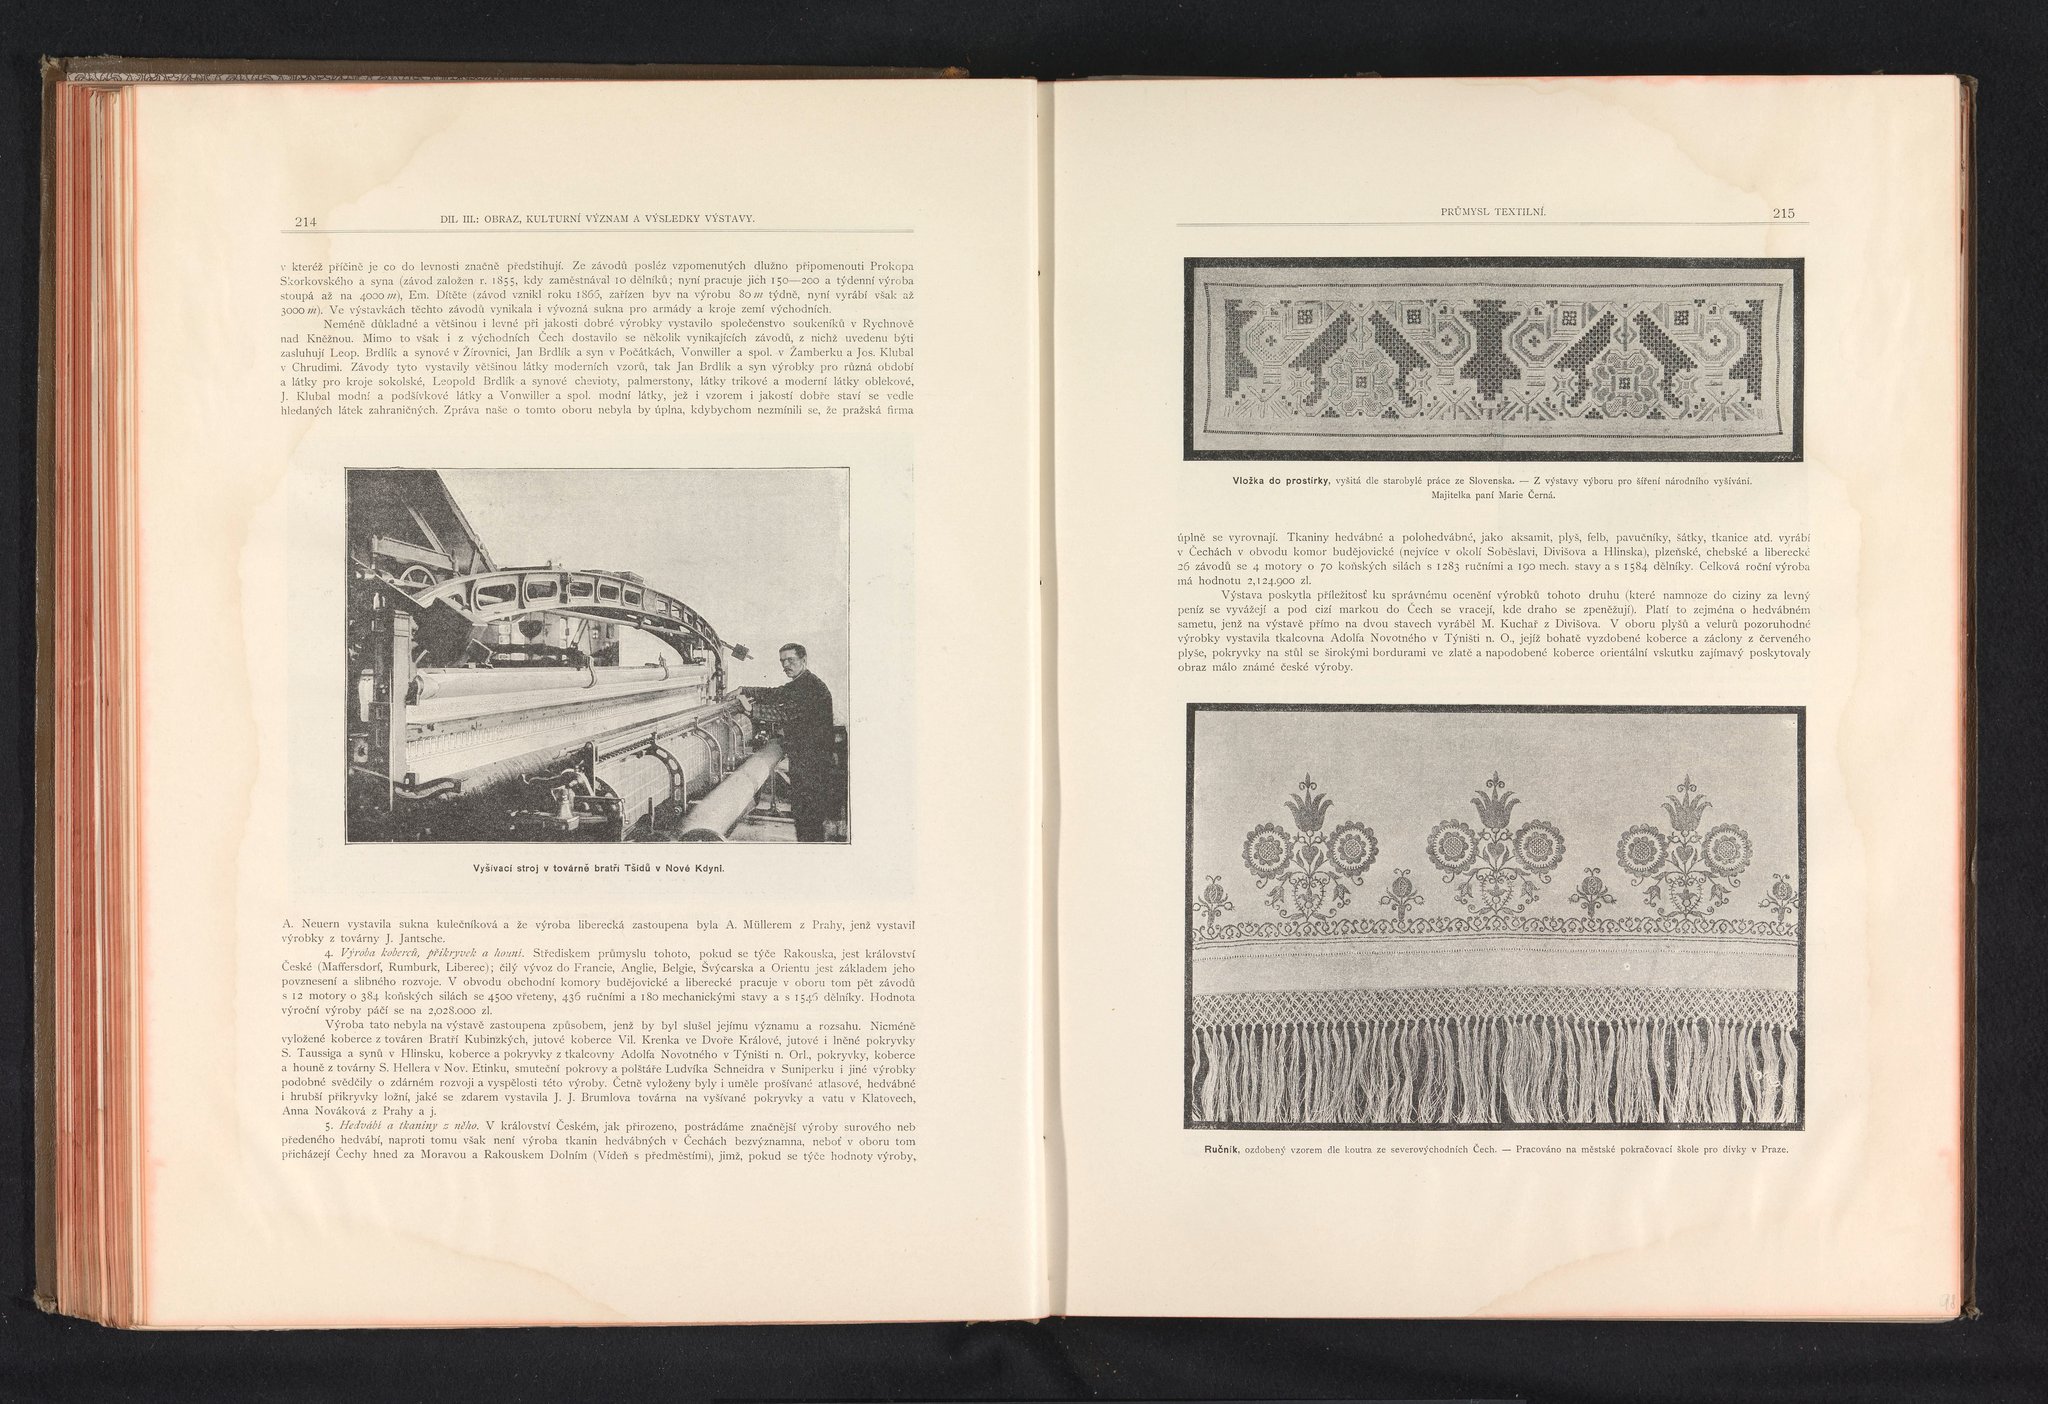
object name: photomechanical print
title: Medewerker naast een borduurmachine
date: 1890-1895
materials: paper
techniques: autotype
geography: prague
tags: embroidering ~ textile industry, machines; parts of machines; tools and appliances